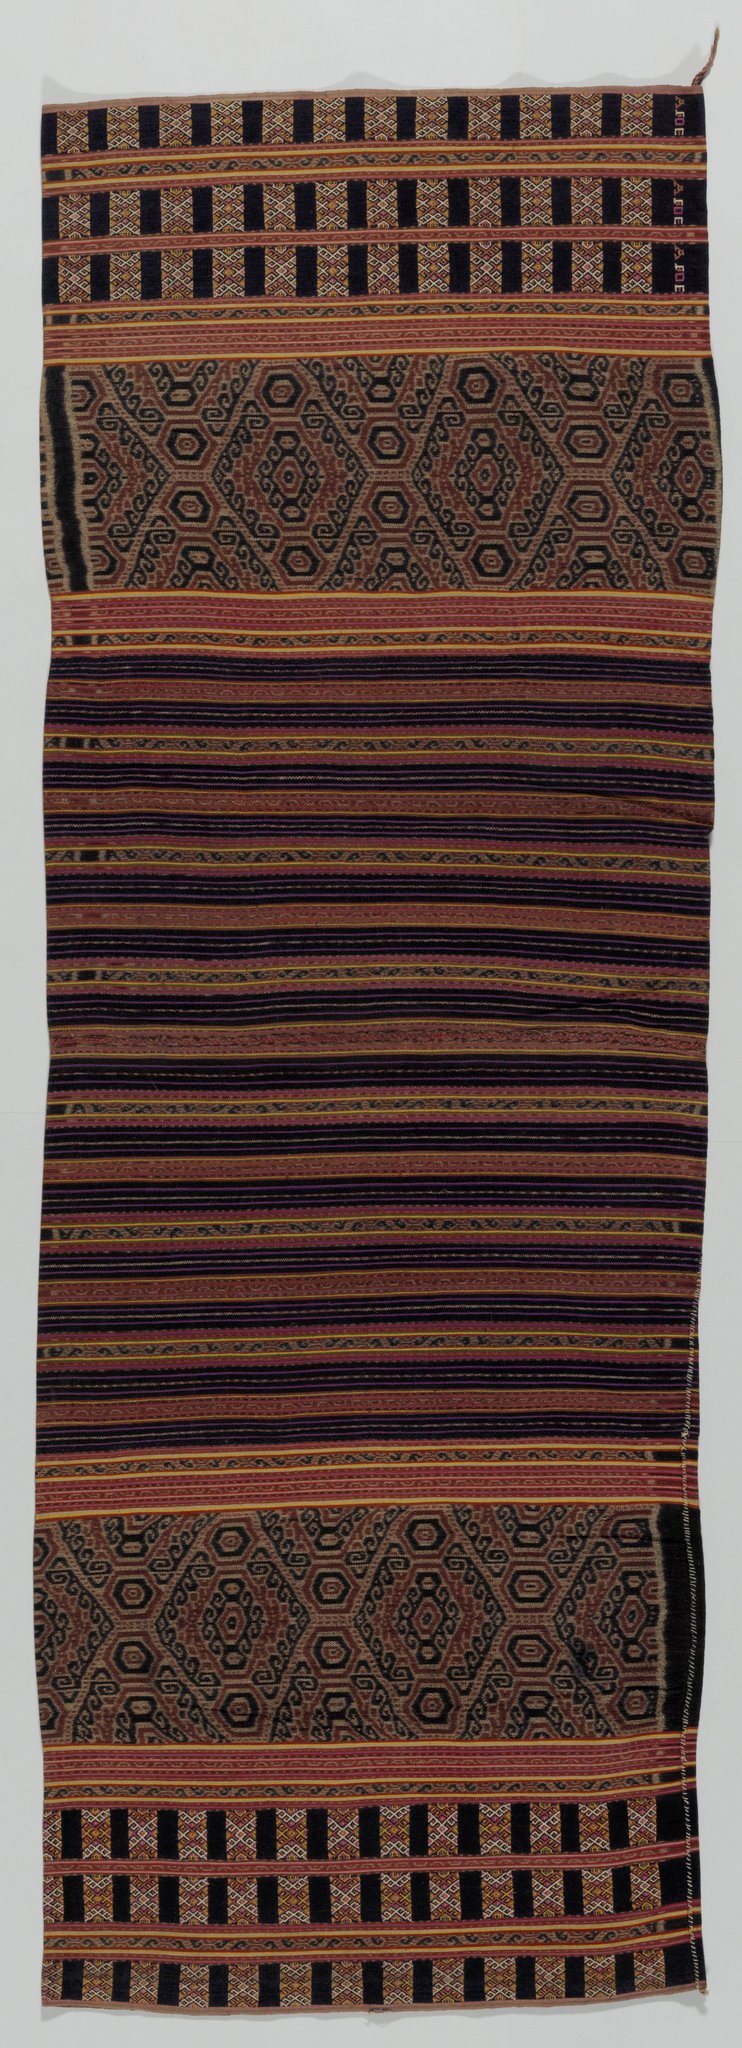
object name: cloth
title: Kokerdoek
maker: Anonymous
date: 1900-1949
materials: cotton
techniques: weave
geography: timor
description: Kokerdoek met haakmotieven en ingeweven tekst.